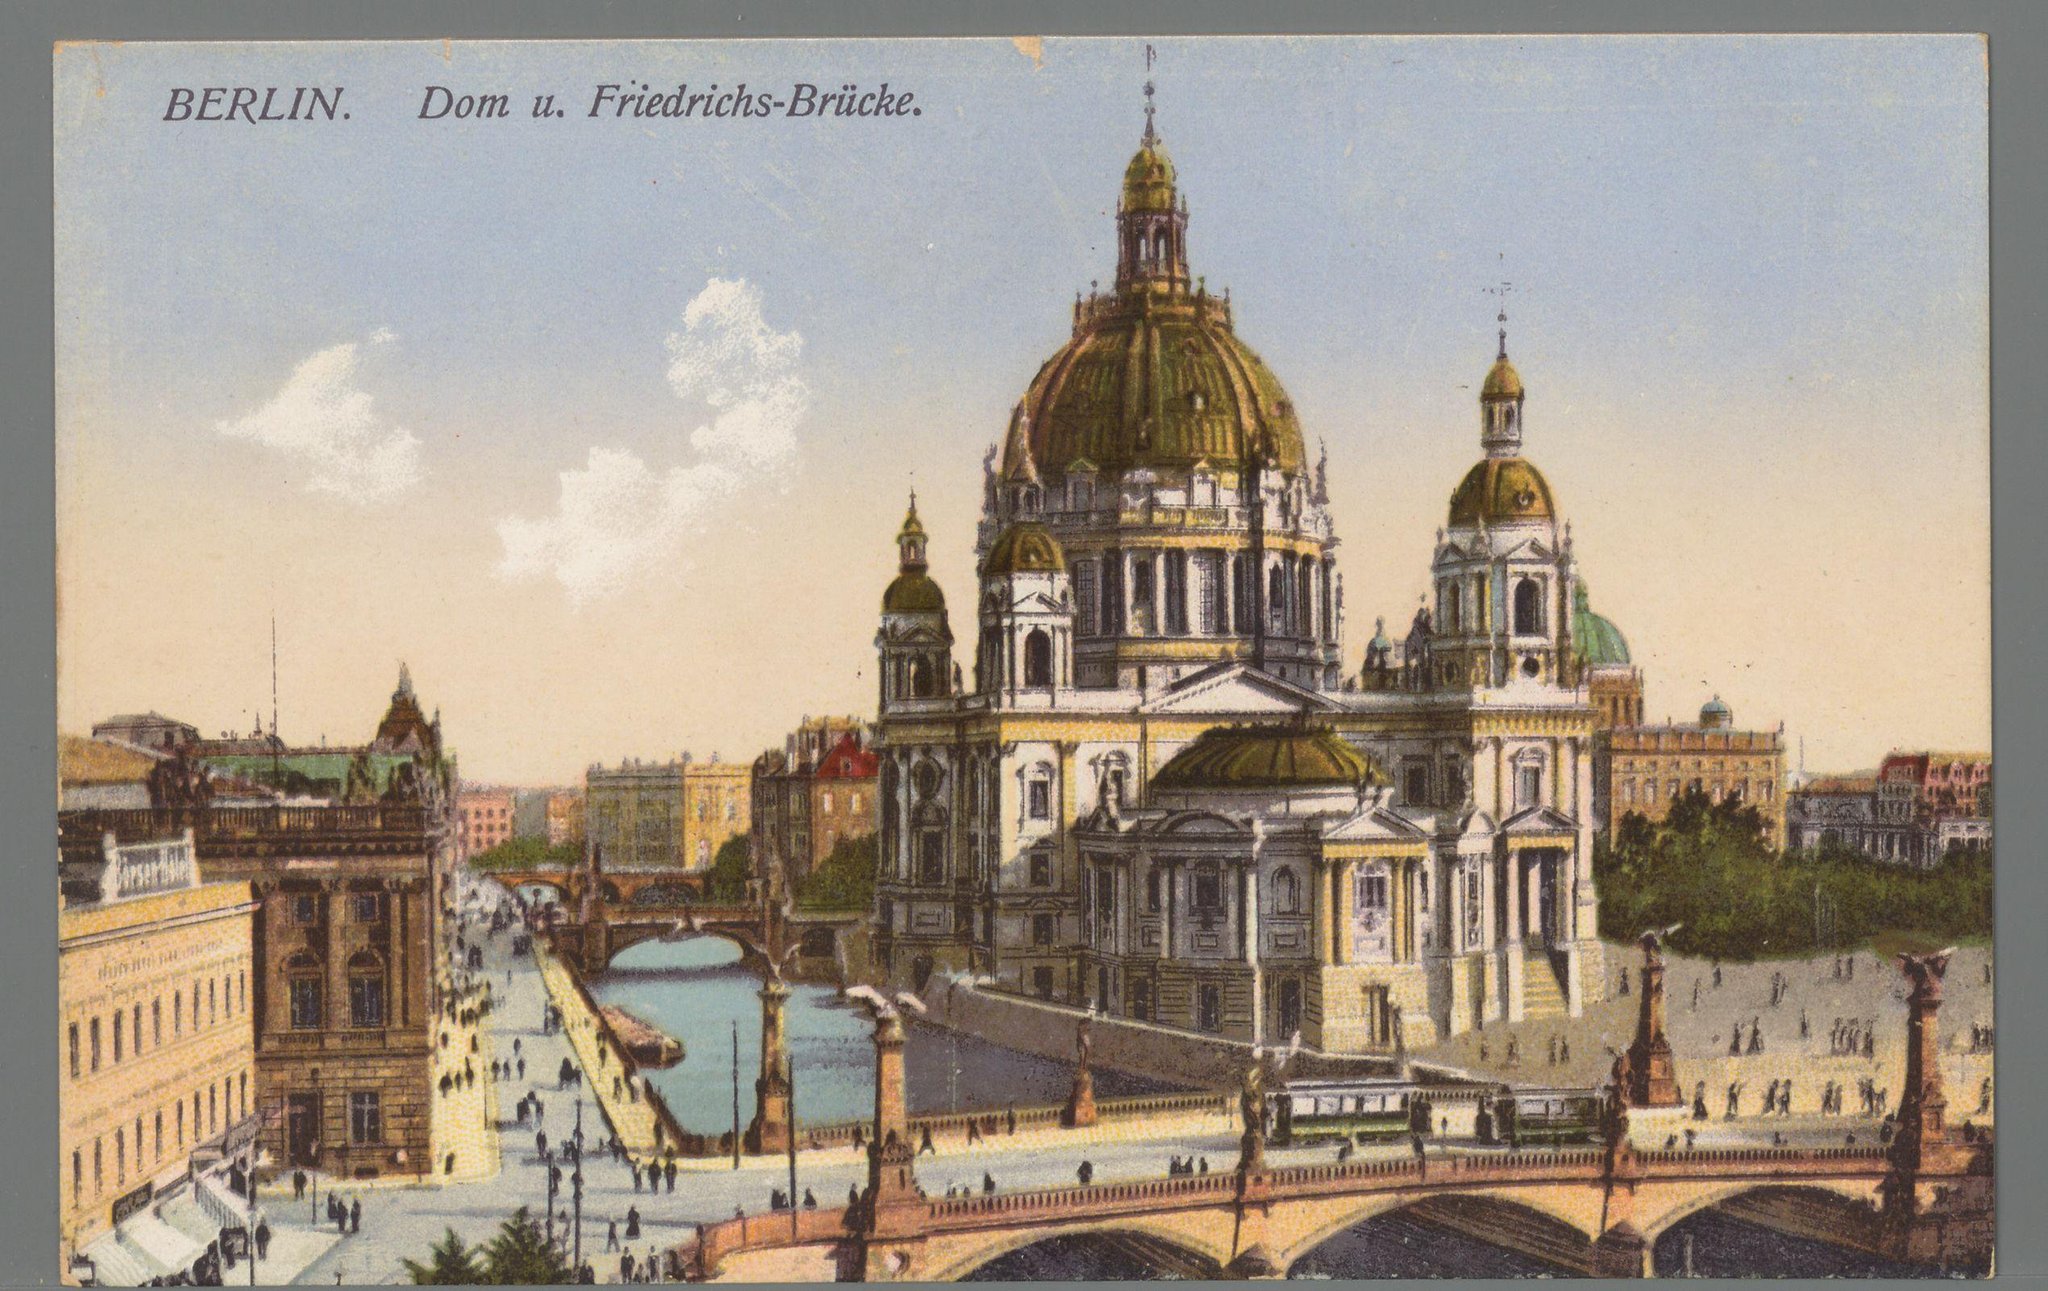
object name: photomechanical print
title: Berlin. Dom u. Friedrichs-Brücke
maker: Anonymous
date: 1905-1930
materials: cardboard, photographic process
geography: berlin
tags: city-view, and landscape with man-made constructions, church (exterior), bridge in city across river, canal, etc.